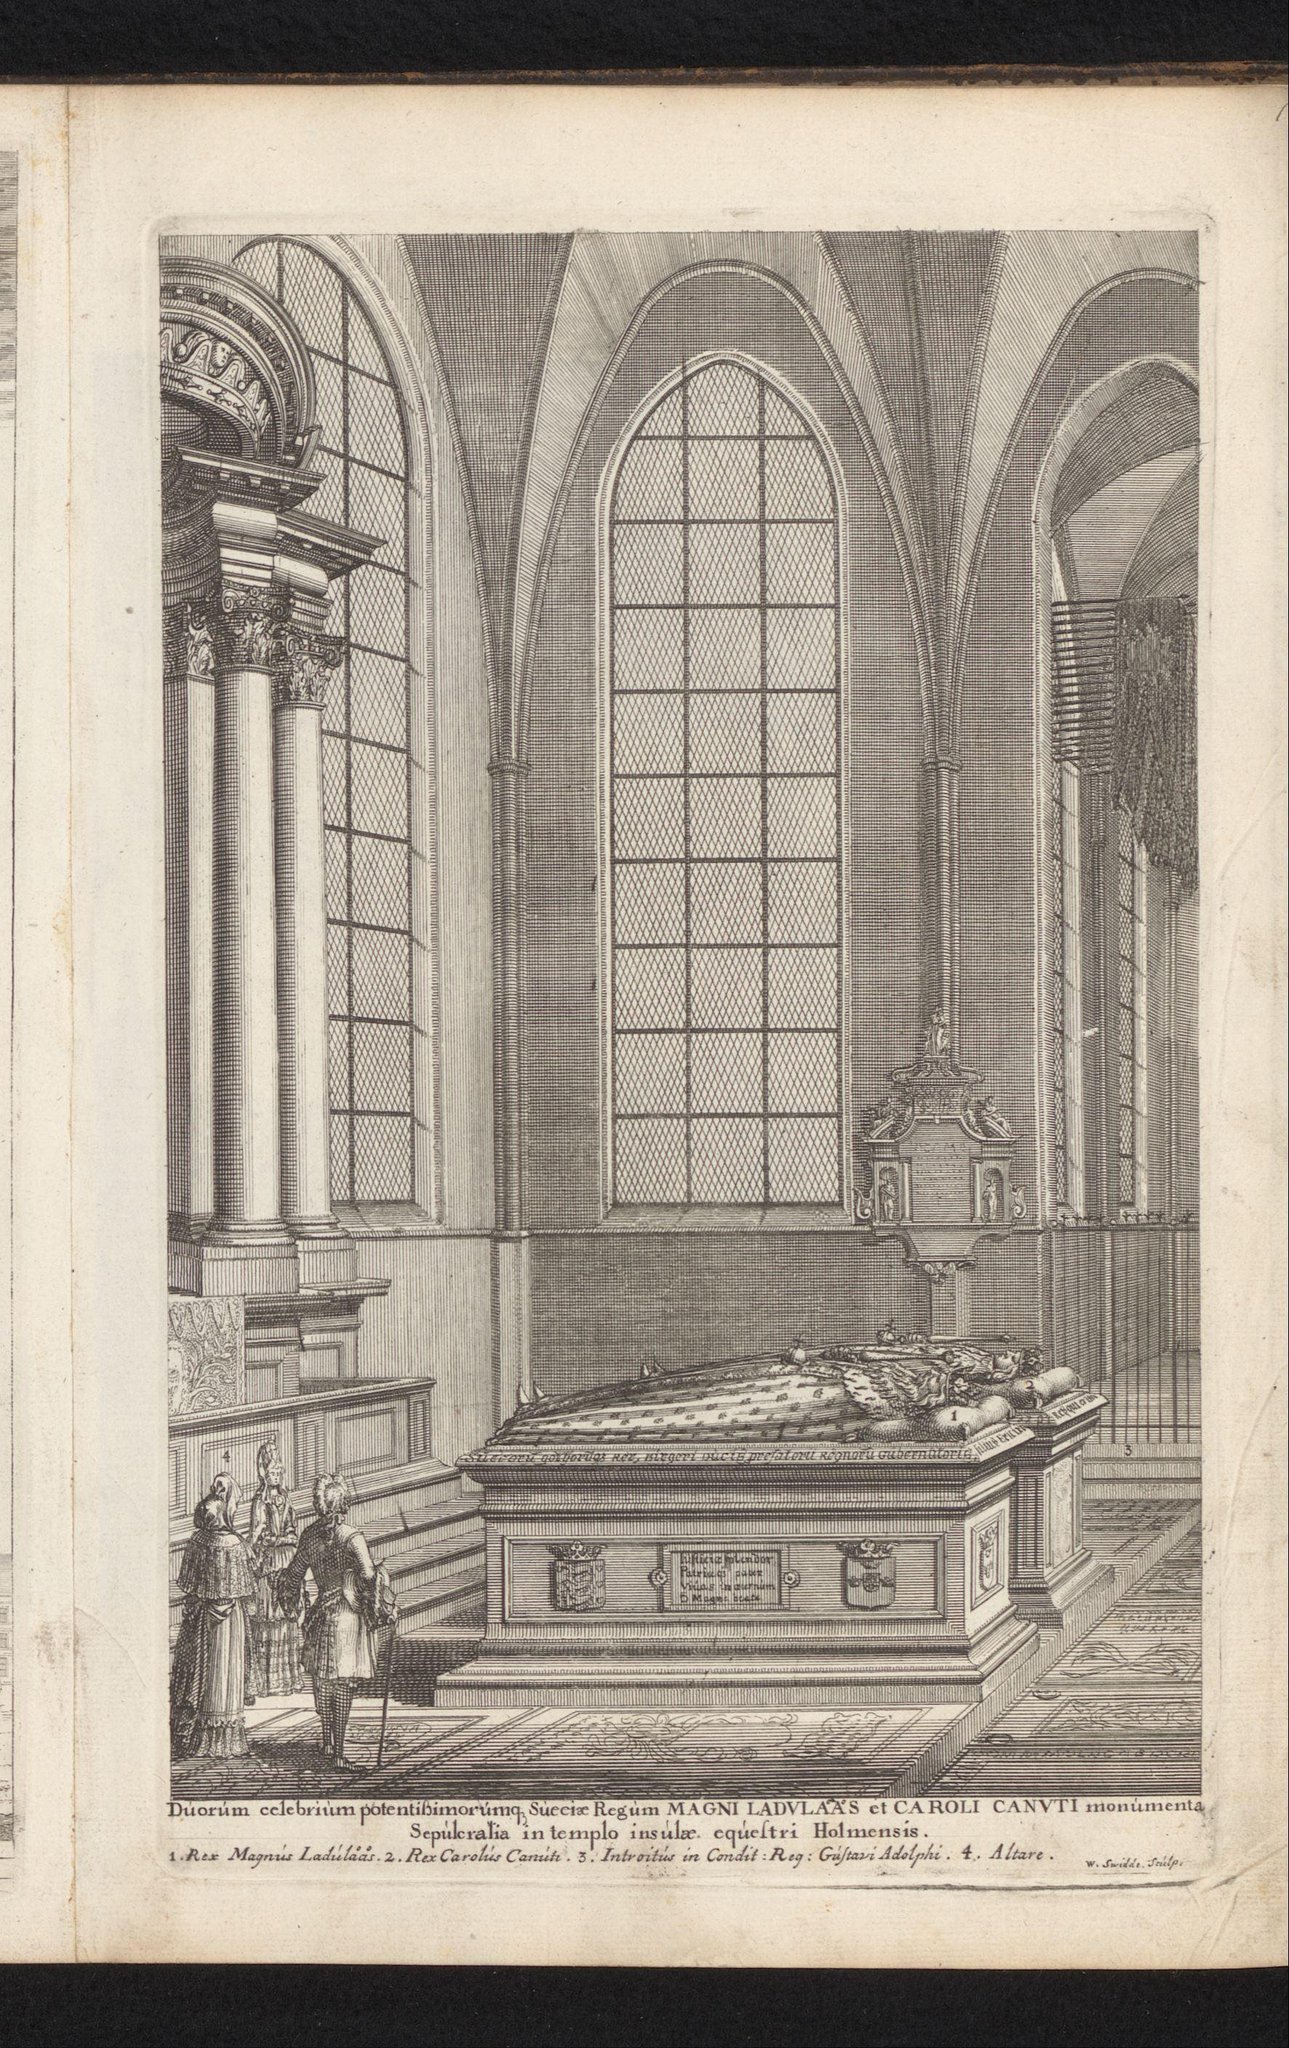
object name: print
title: Duorum celebrium potentissimorumq(ue) Sueciae Regum Magni Ladulåås et Caroli Canuti monumenta Sepulcralia in templo insulae equestri Holmensis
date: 1696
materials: paper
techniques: etching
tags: grave-building, monumental tomb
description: De grafmonumenten van Magnus III en Karel VIII, koningen van Zweden, in de kerk van Riddarholmen. De prent maakt deel uit van een album.